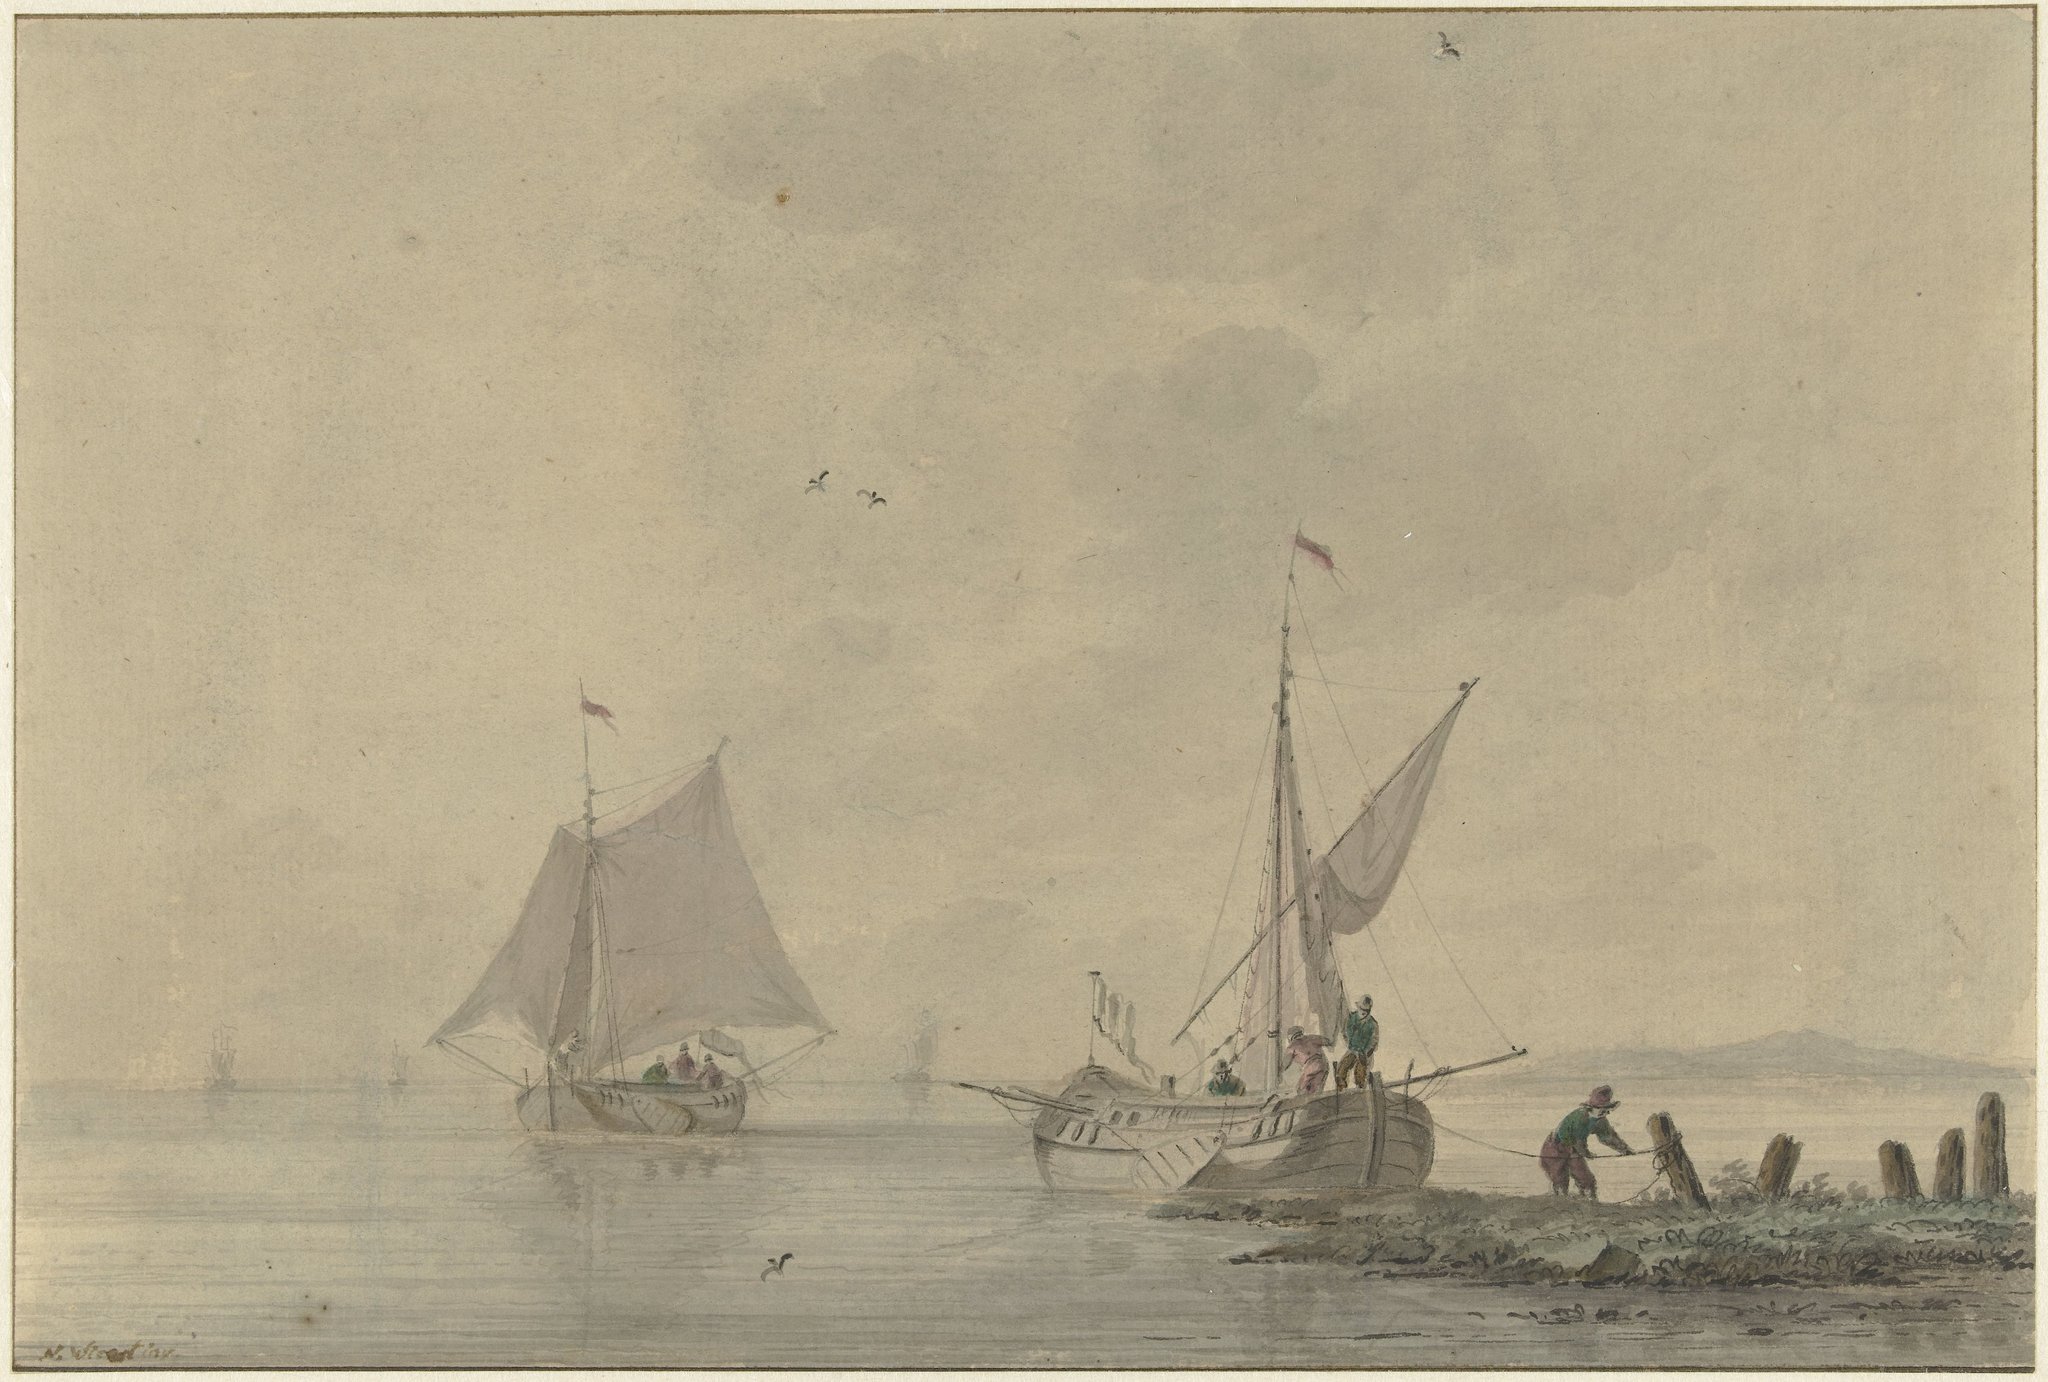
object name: drawing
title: Stil binnenwater met aanleggende boot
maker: nicolaas wicart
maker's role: draughtsman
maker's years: 1748-1815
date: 1758-1815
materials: ink, paper, watercolor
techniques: brush, pen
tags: sailing-ship, sailing-boat, river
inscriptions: inscription: ‘N Wicart inv’